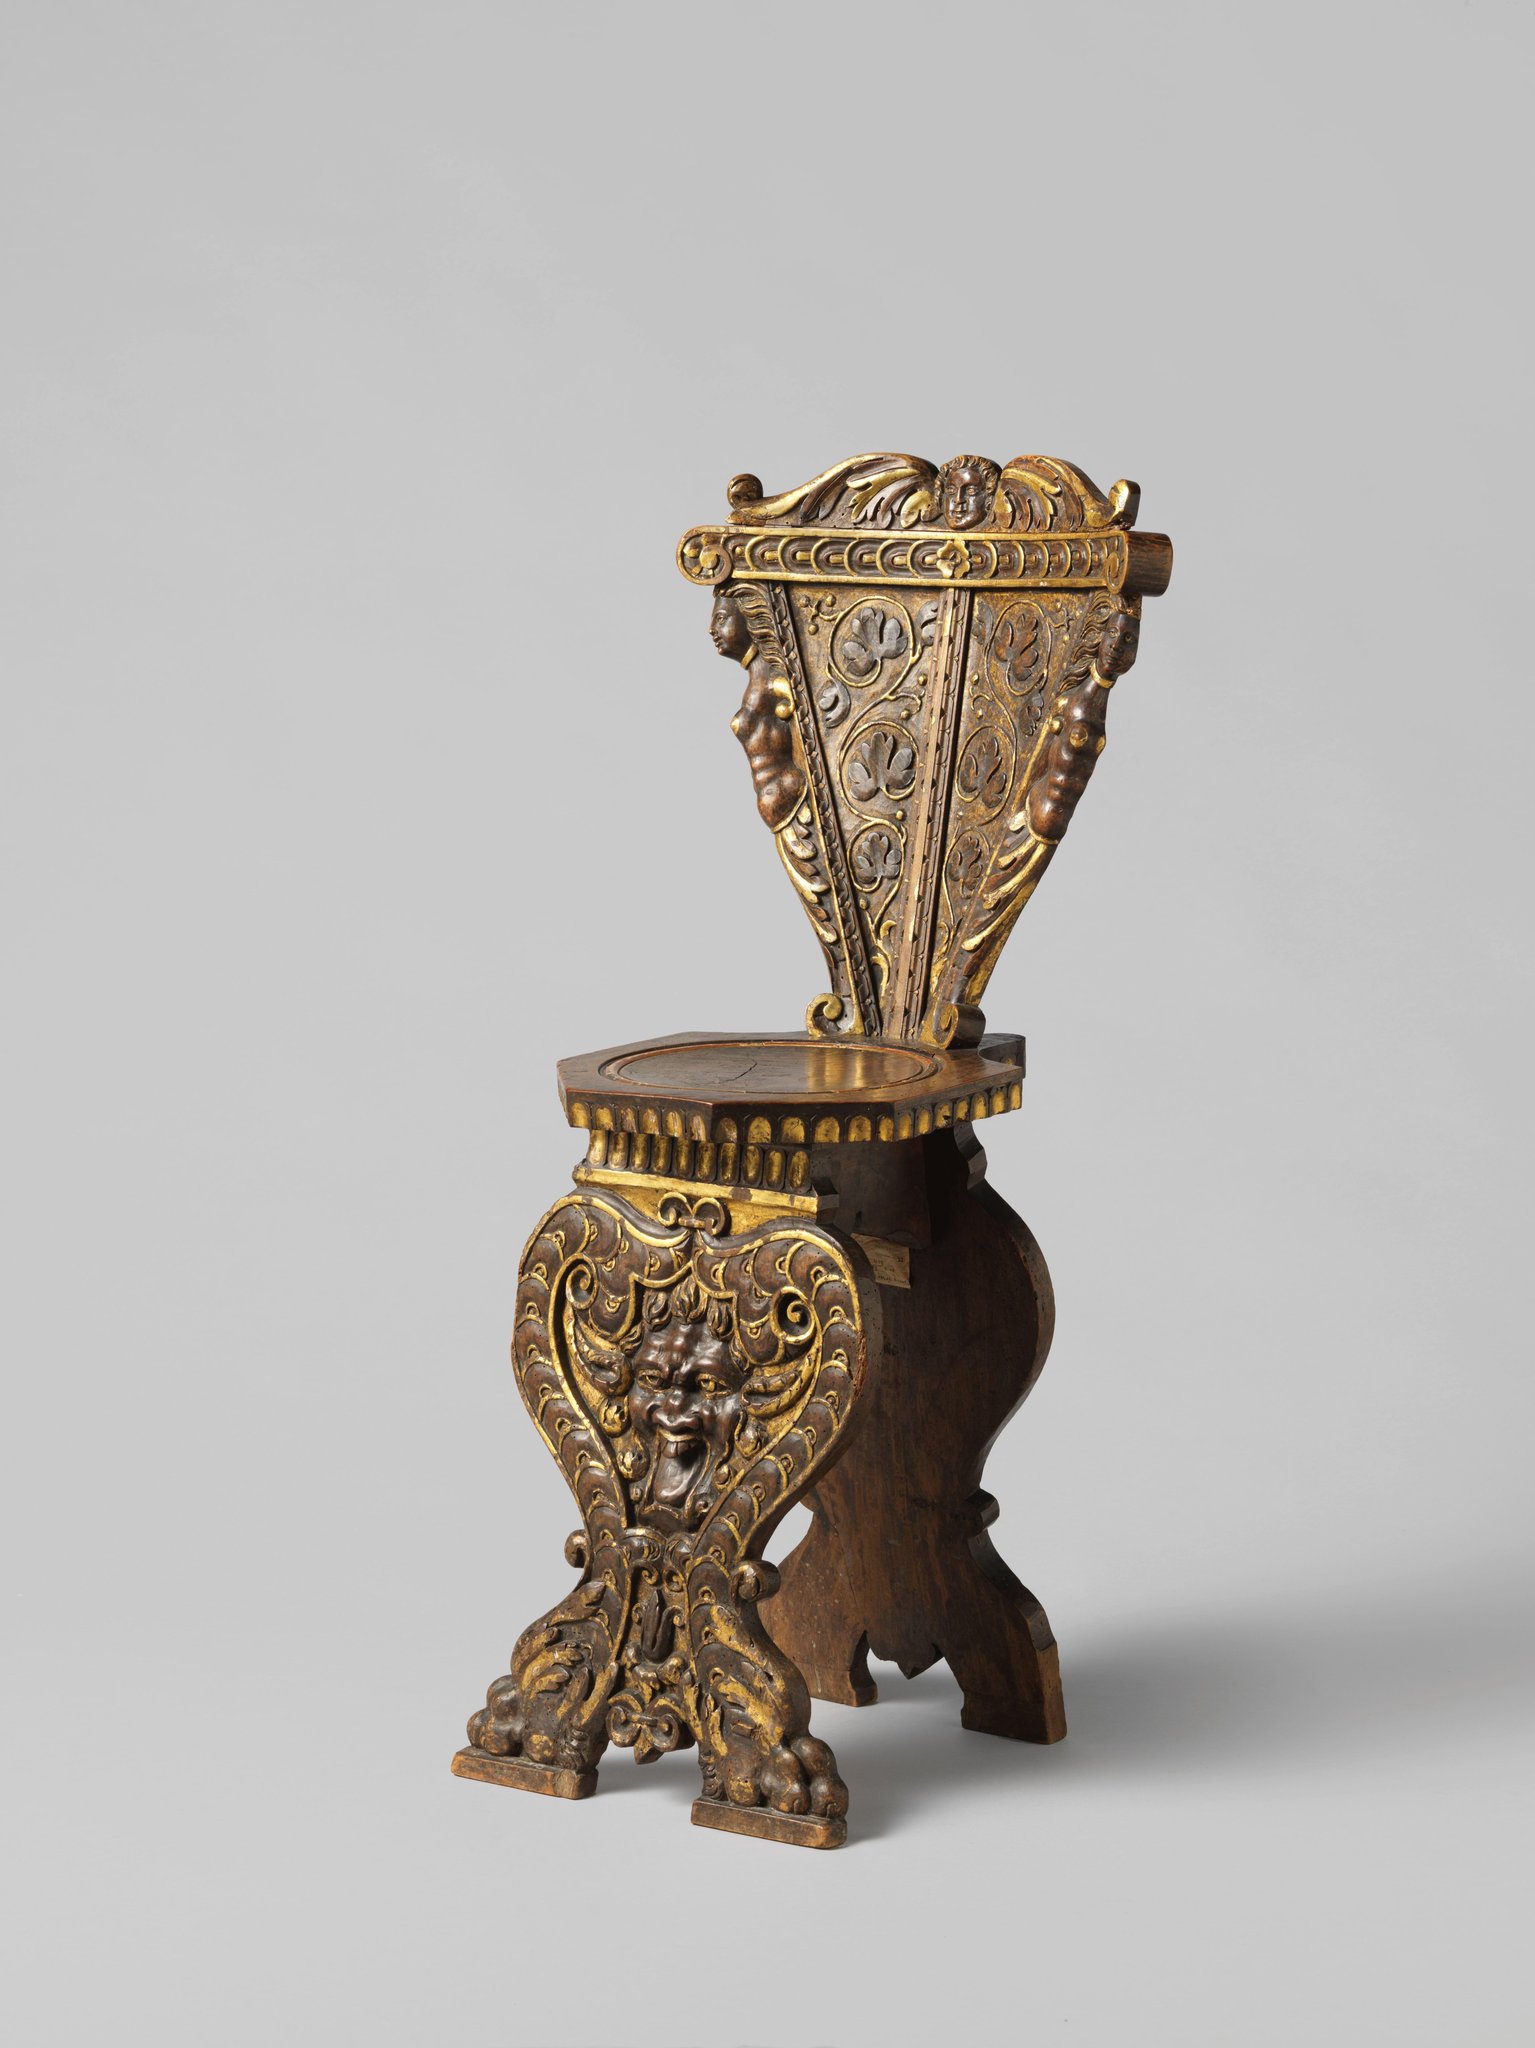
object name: furniture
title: Stoel van gedeeltelijk verguld notenhout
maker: Anonymous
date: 1550-1600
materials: wood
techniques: gilding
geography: italy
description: Stoel van gedeeltelijk verguld notenhout, met in gespreide stand geplaatst, voor- en achterbord. Het voorbord vertoont ondermeer in laag reliëf een duivelsmasker, geflankeerd door S-voluten, eindigend in dierenklauwen met acanthusblad. De rug heeft de vorm van een omgekeerde gelijkbenige driehoek, met twee met bladranken versierde panelen. Tegen de hoeken staan vrouwenfiguren als caryatiden, wier onderlijf in acanthusblad en voluut eindigt. Ter bekroning een uitgezaagd opzetstuk met kinderkopje en voluten.